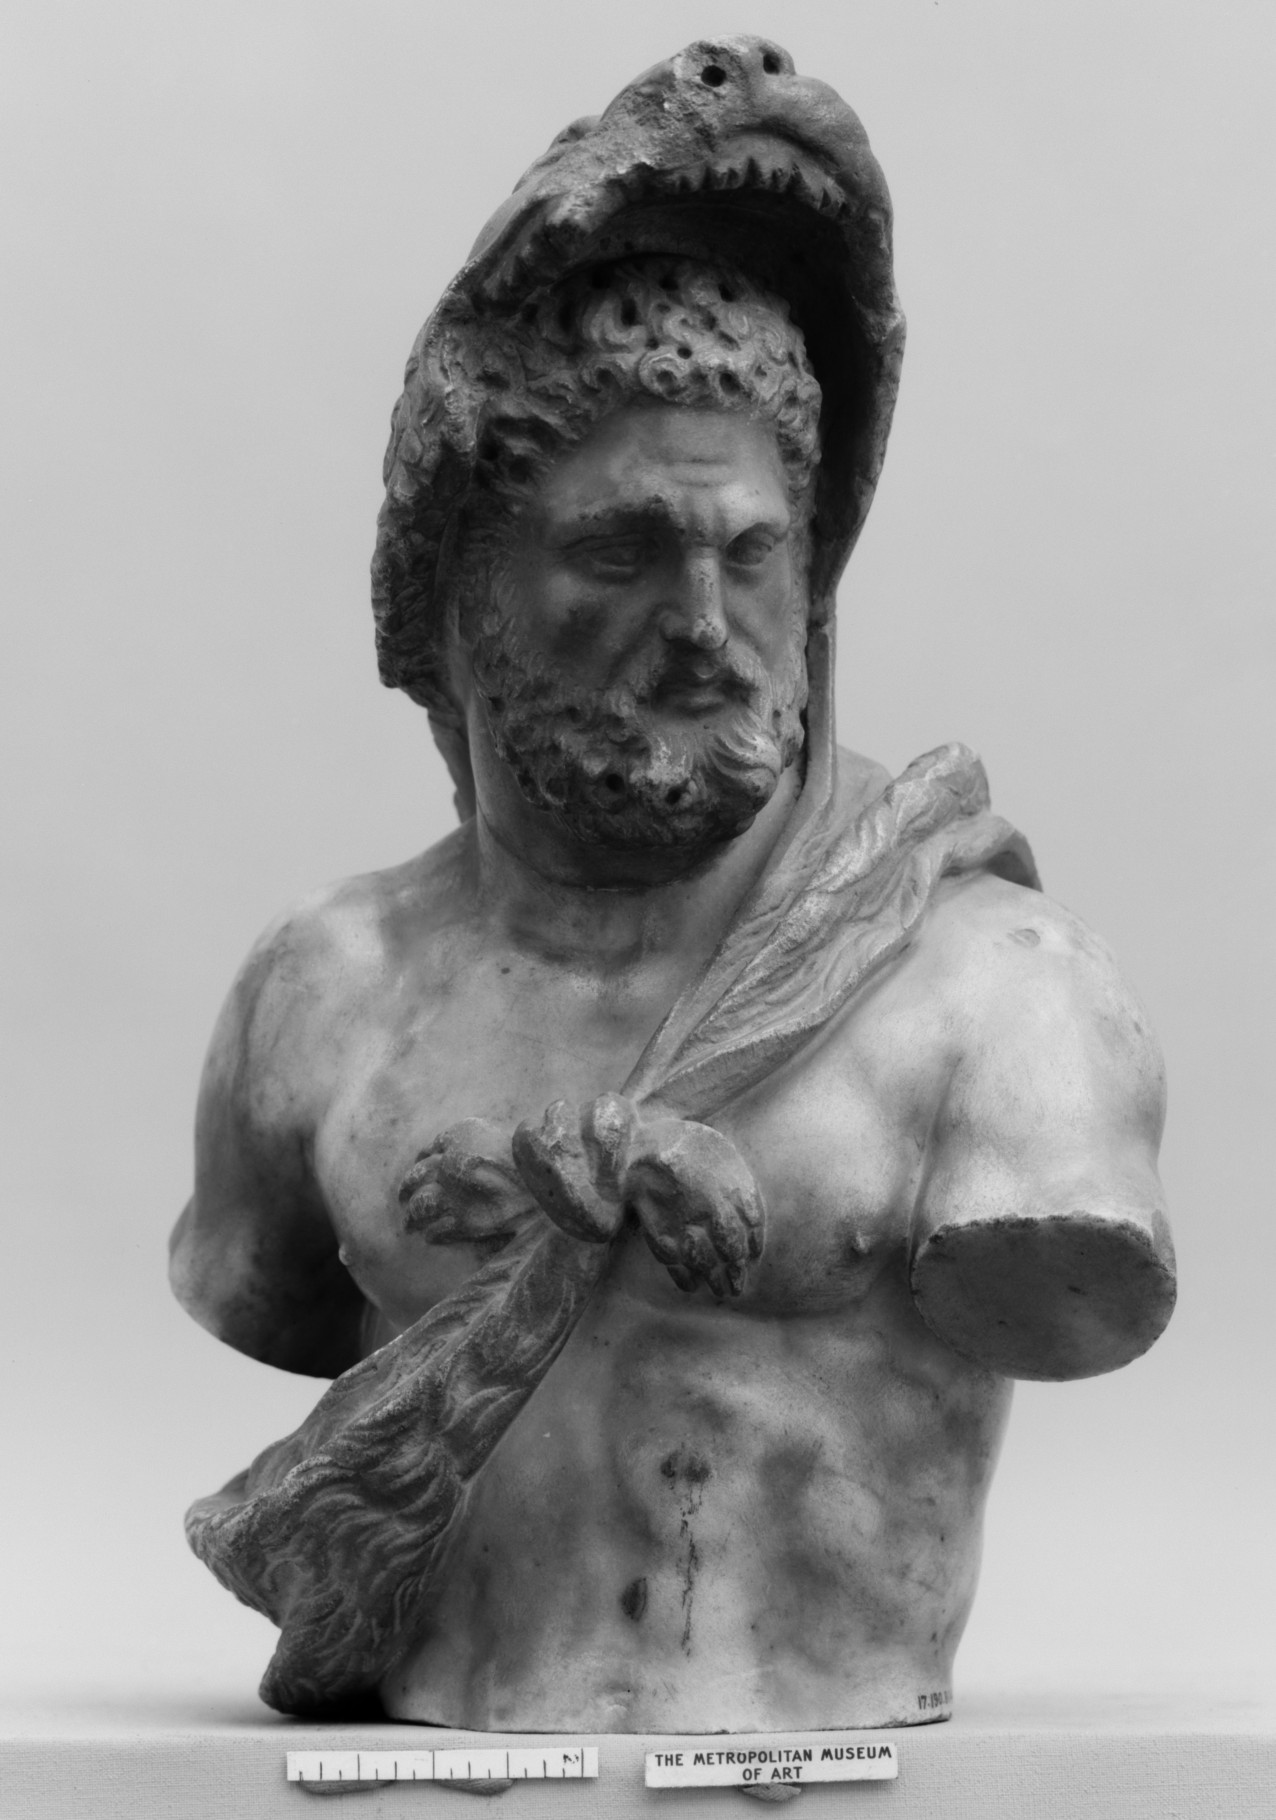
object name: half length statue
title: Hercules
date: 1500-1550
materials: marble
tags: hercules